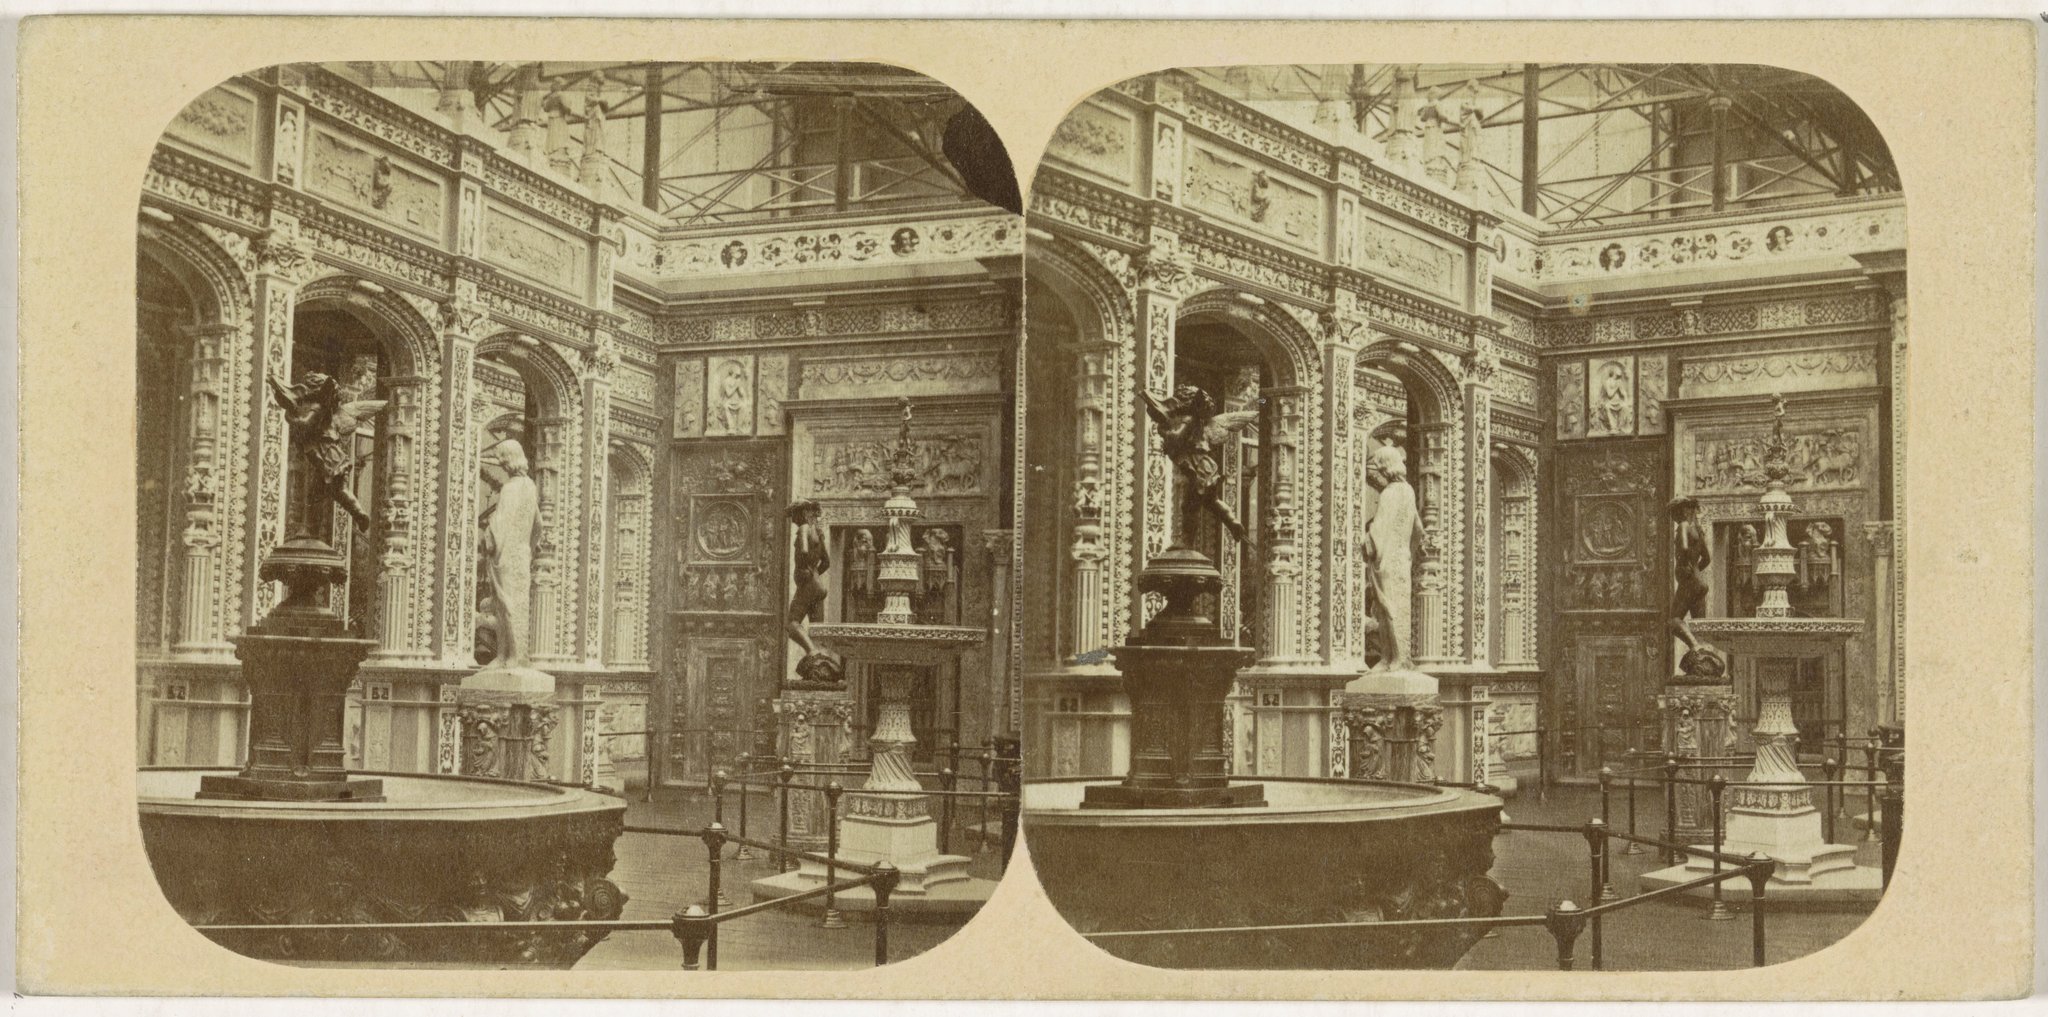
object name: stereograph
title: Interieur van het Crystal Palace, Sydenham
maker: Anonymous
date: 1862-1875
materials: cardboard, paper, photographic support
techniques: albumen print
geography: england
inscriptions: inscription: ‘CRYSTAL PALACE. / 47. VIEW IN THE RENAISSANCE COURT.’